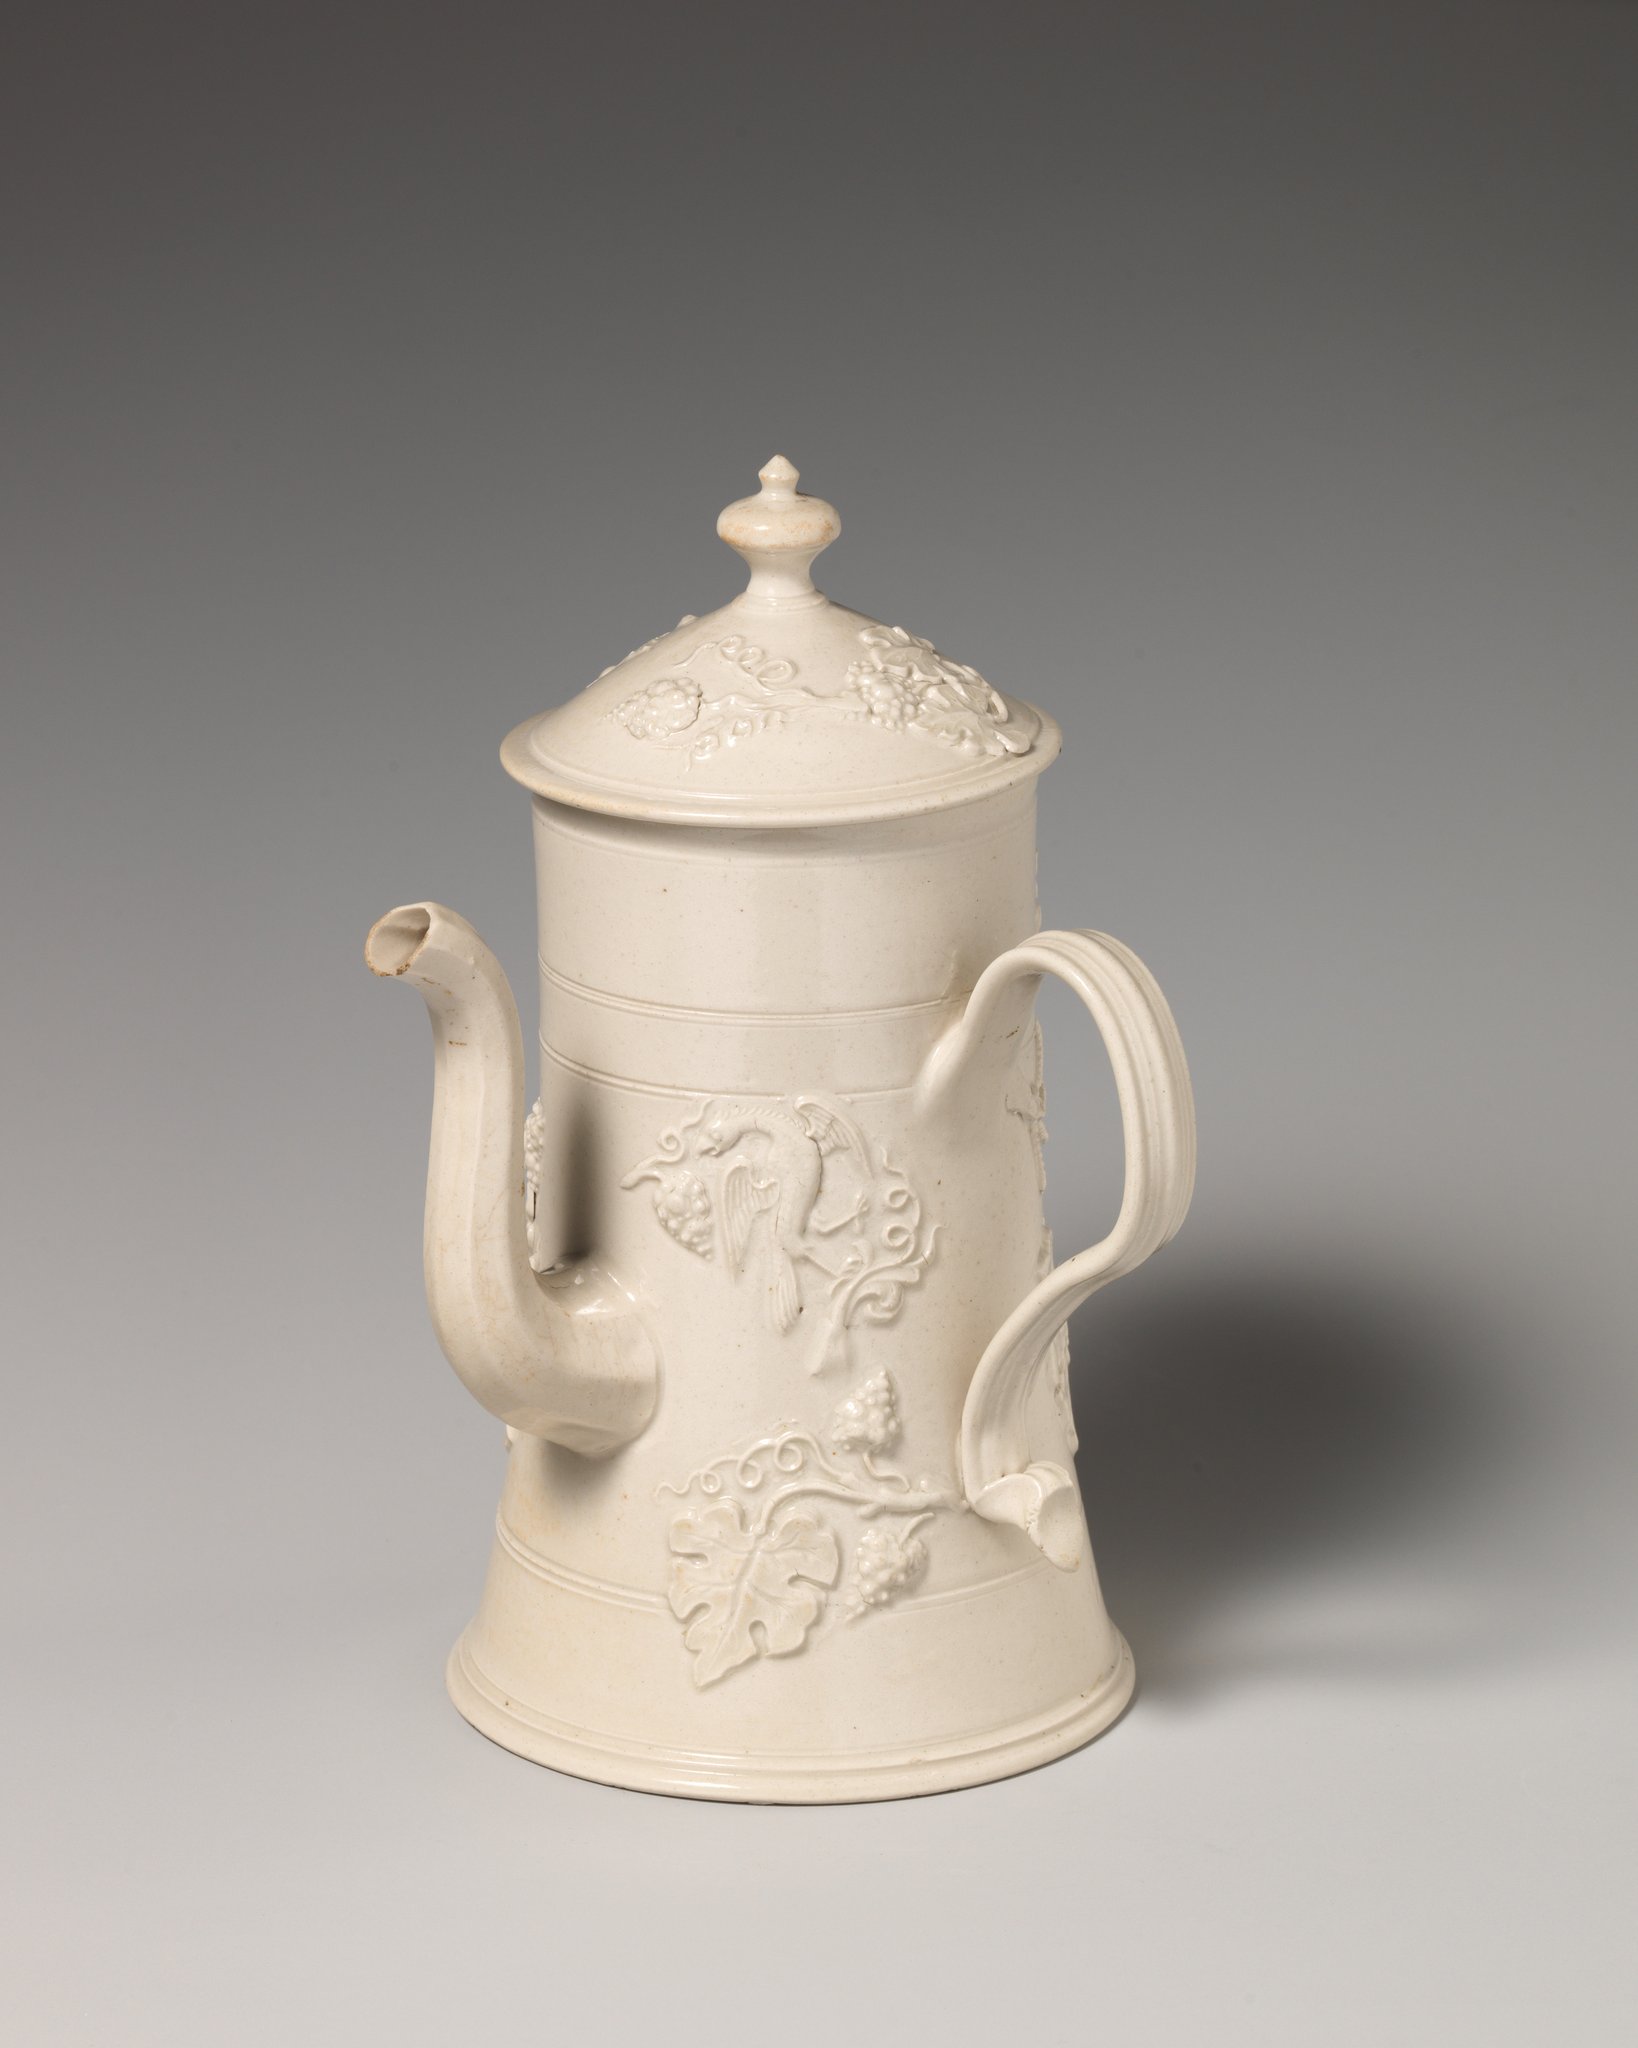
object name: coffeepot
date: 1740-1750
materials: stoneware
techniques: salt glaze